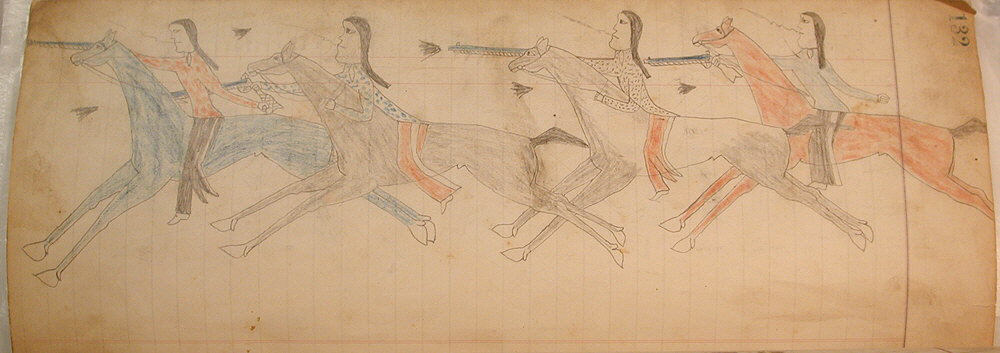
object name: drawing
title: Maffet Ledger: Drawing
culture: cheyenne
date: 1874-1881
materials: crayon, graphite, paper, watercolor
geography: united states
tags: firearms,horses